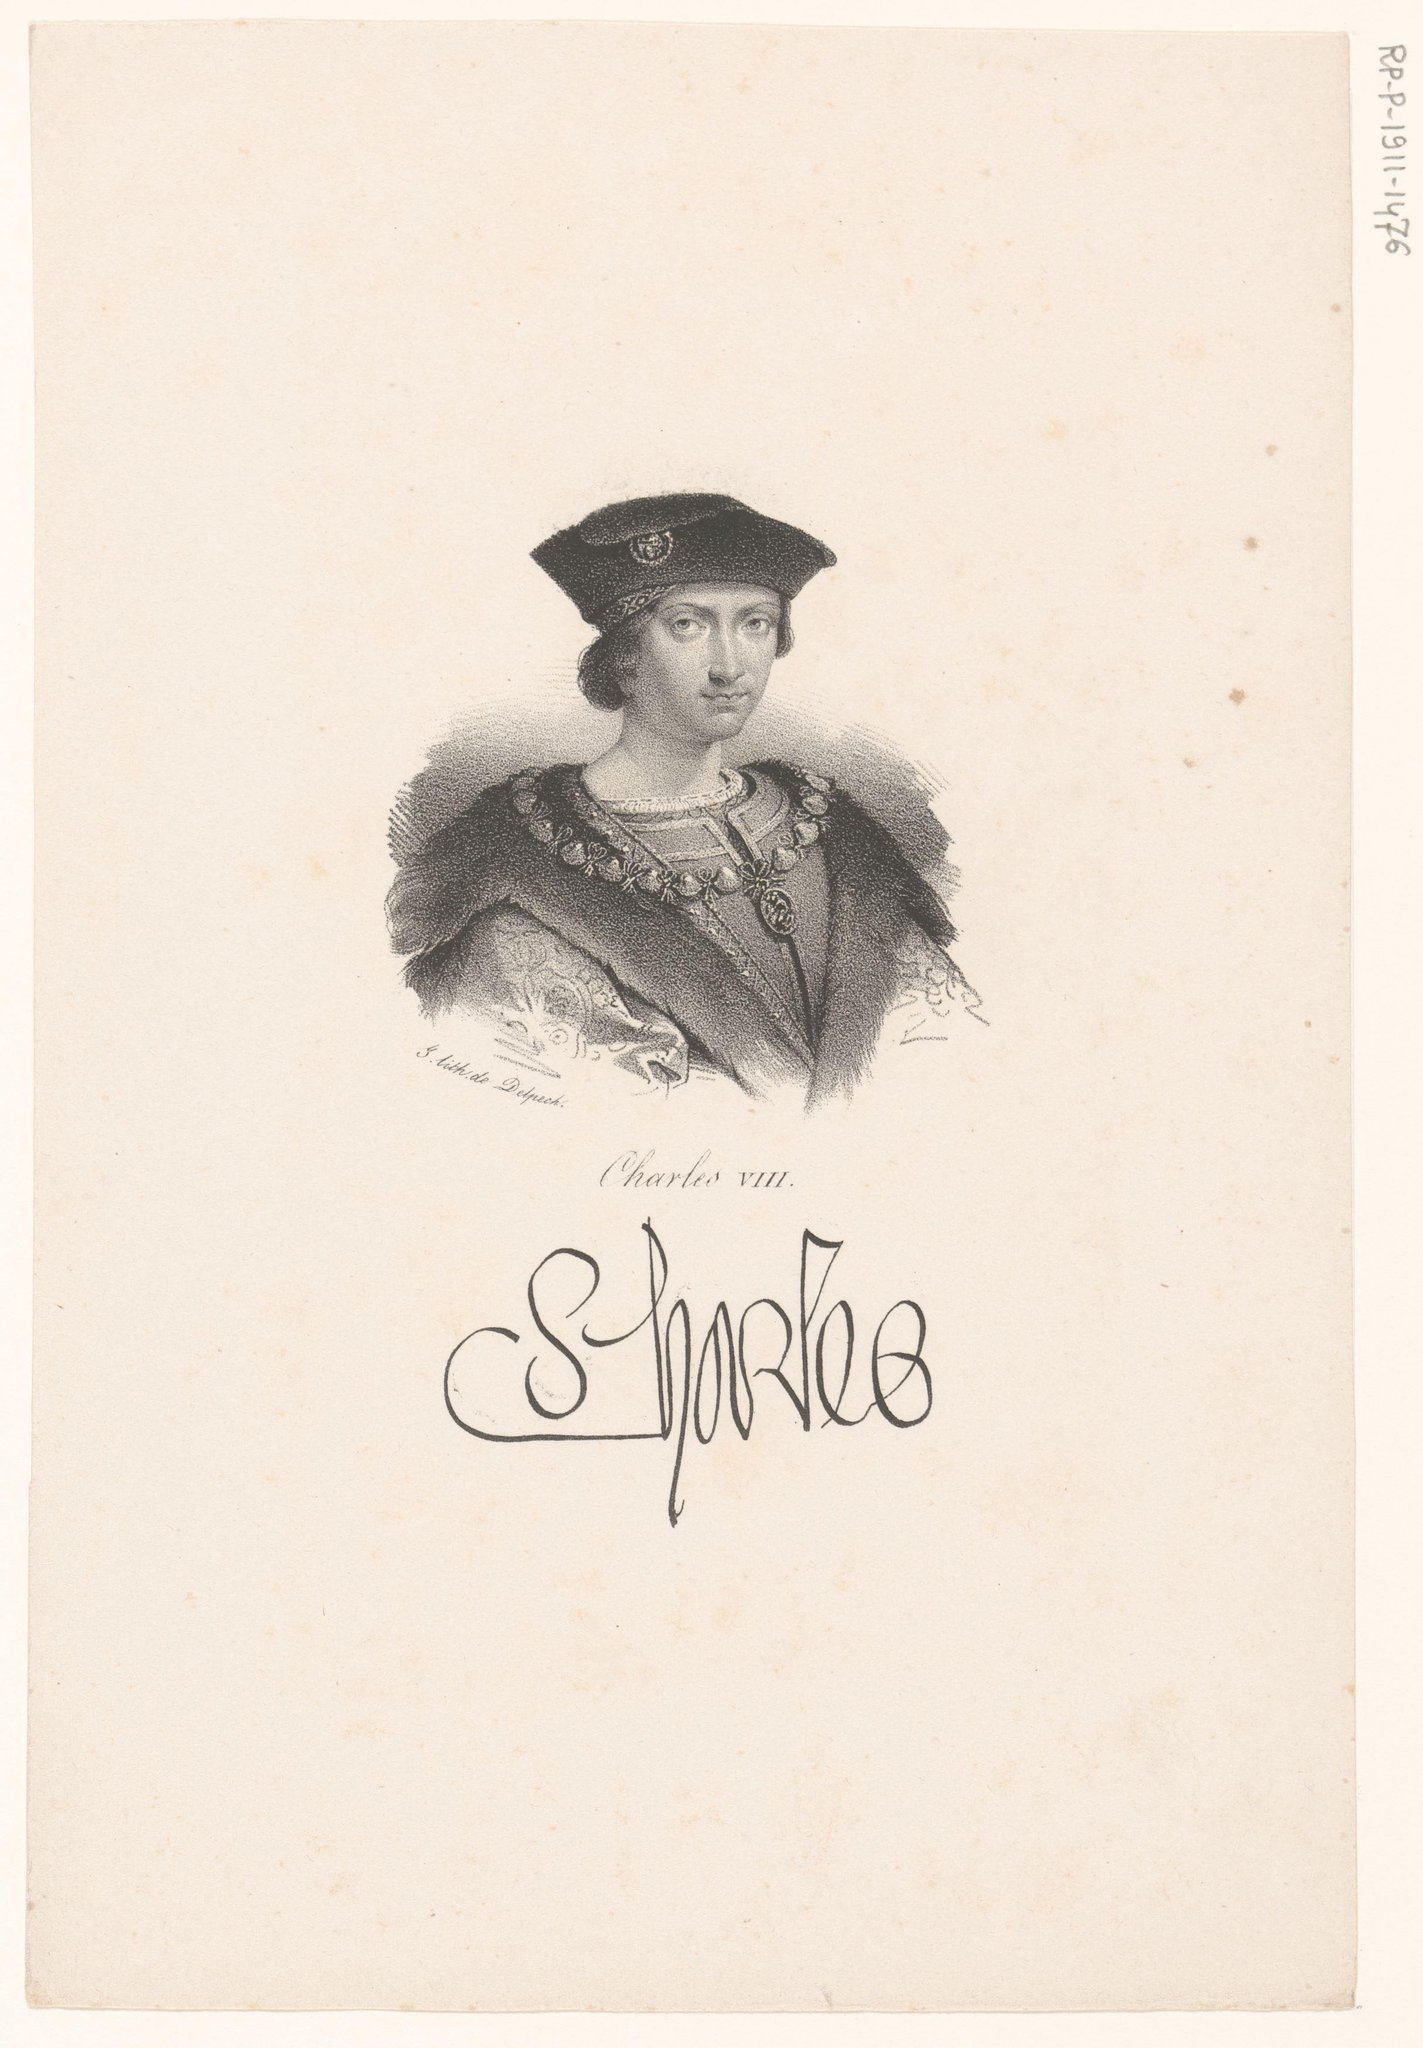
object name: print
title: Portret van Karel VIII van Frankrijk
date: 1818-1842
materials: paper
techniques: lithograph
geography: paris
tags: historical persons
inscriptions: collector's mark: Lugt 2228a